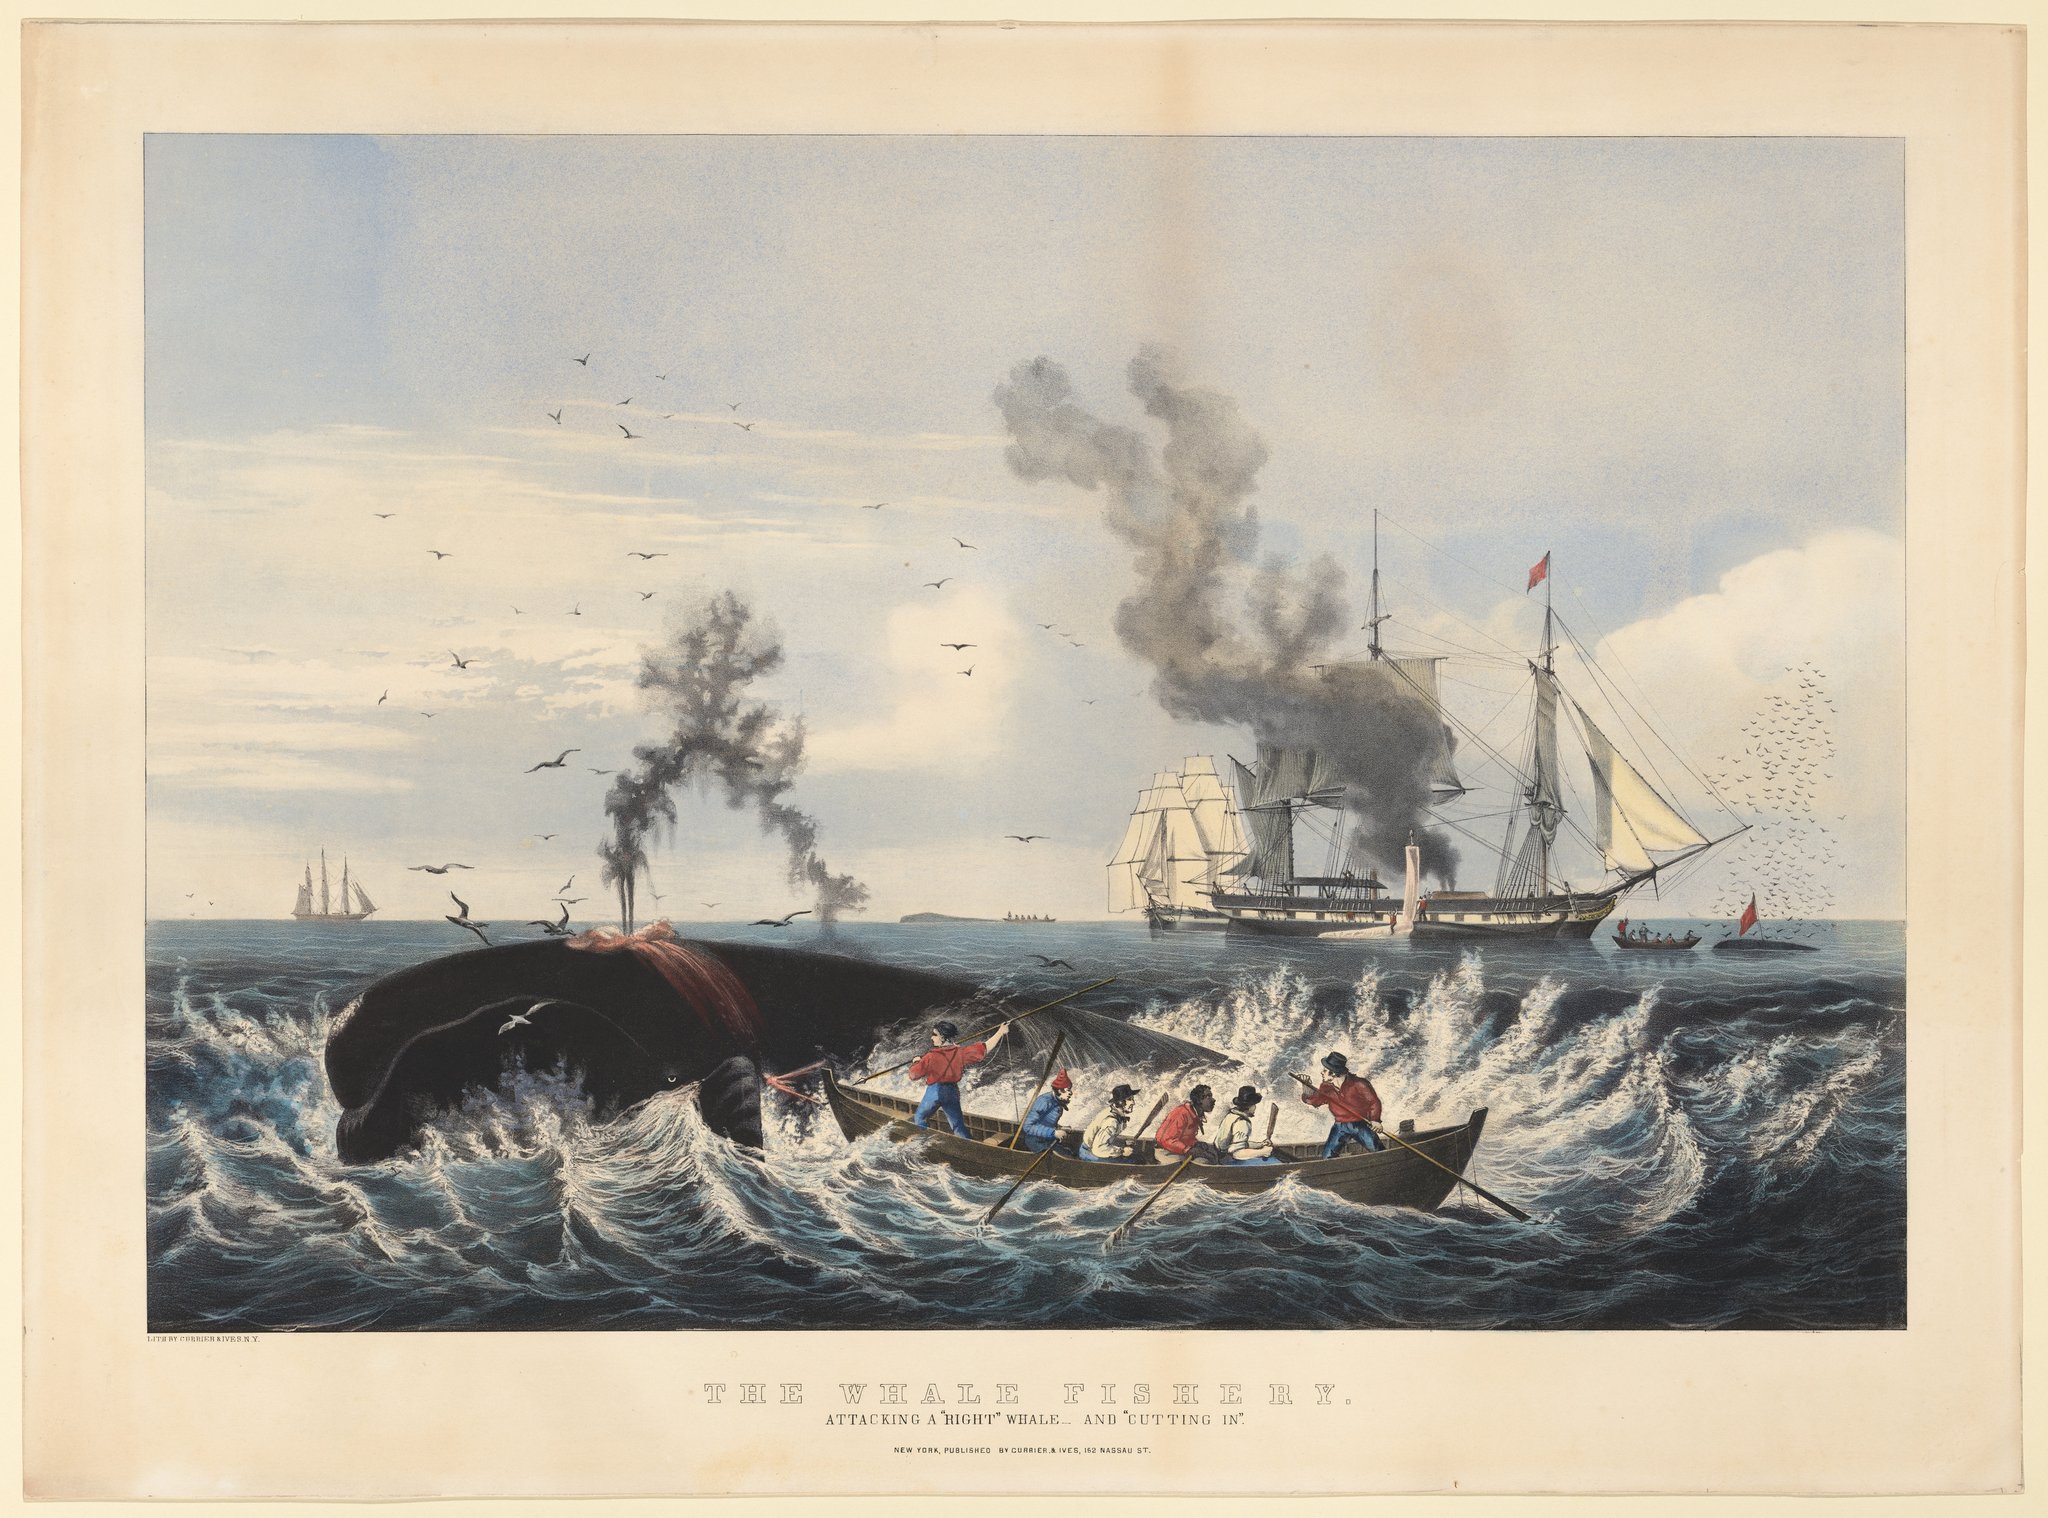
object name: print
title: The Whale Fishery: Attacking a "Right Whale" --and "Cutting In"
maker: currier & ives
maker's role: publisher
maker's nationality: american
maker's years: 1857-1907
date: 1860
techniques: hand coloring, lithograph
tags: whales,boats